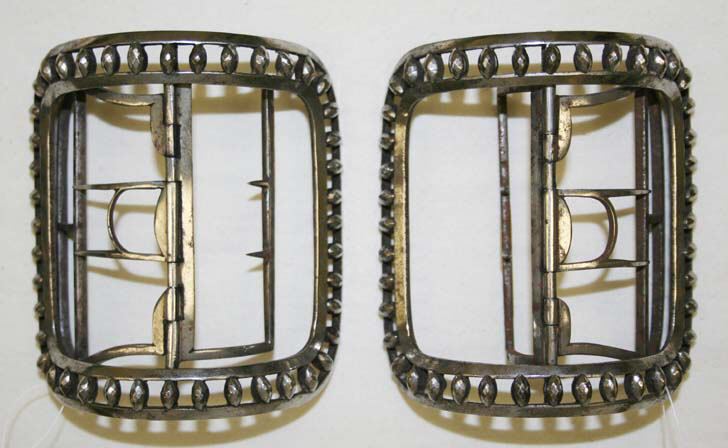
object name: shoe buckle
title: Shoe buckles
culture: european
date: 1767-1800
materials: steel